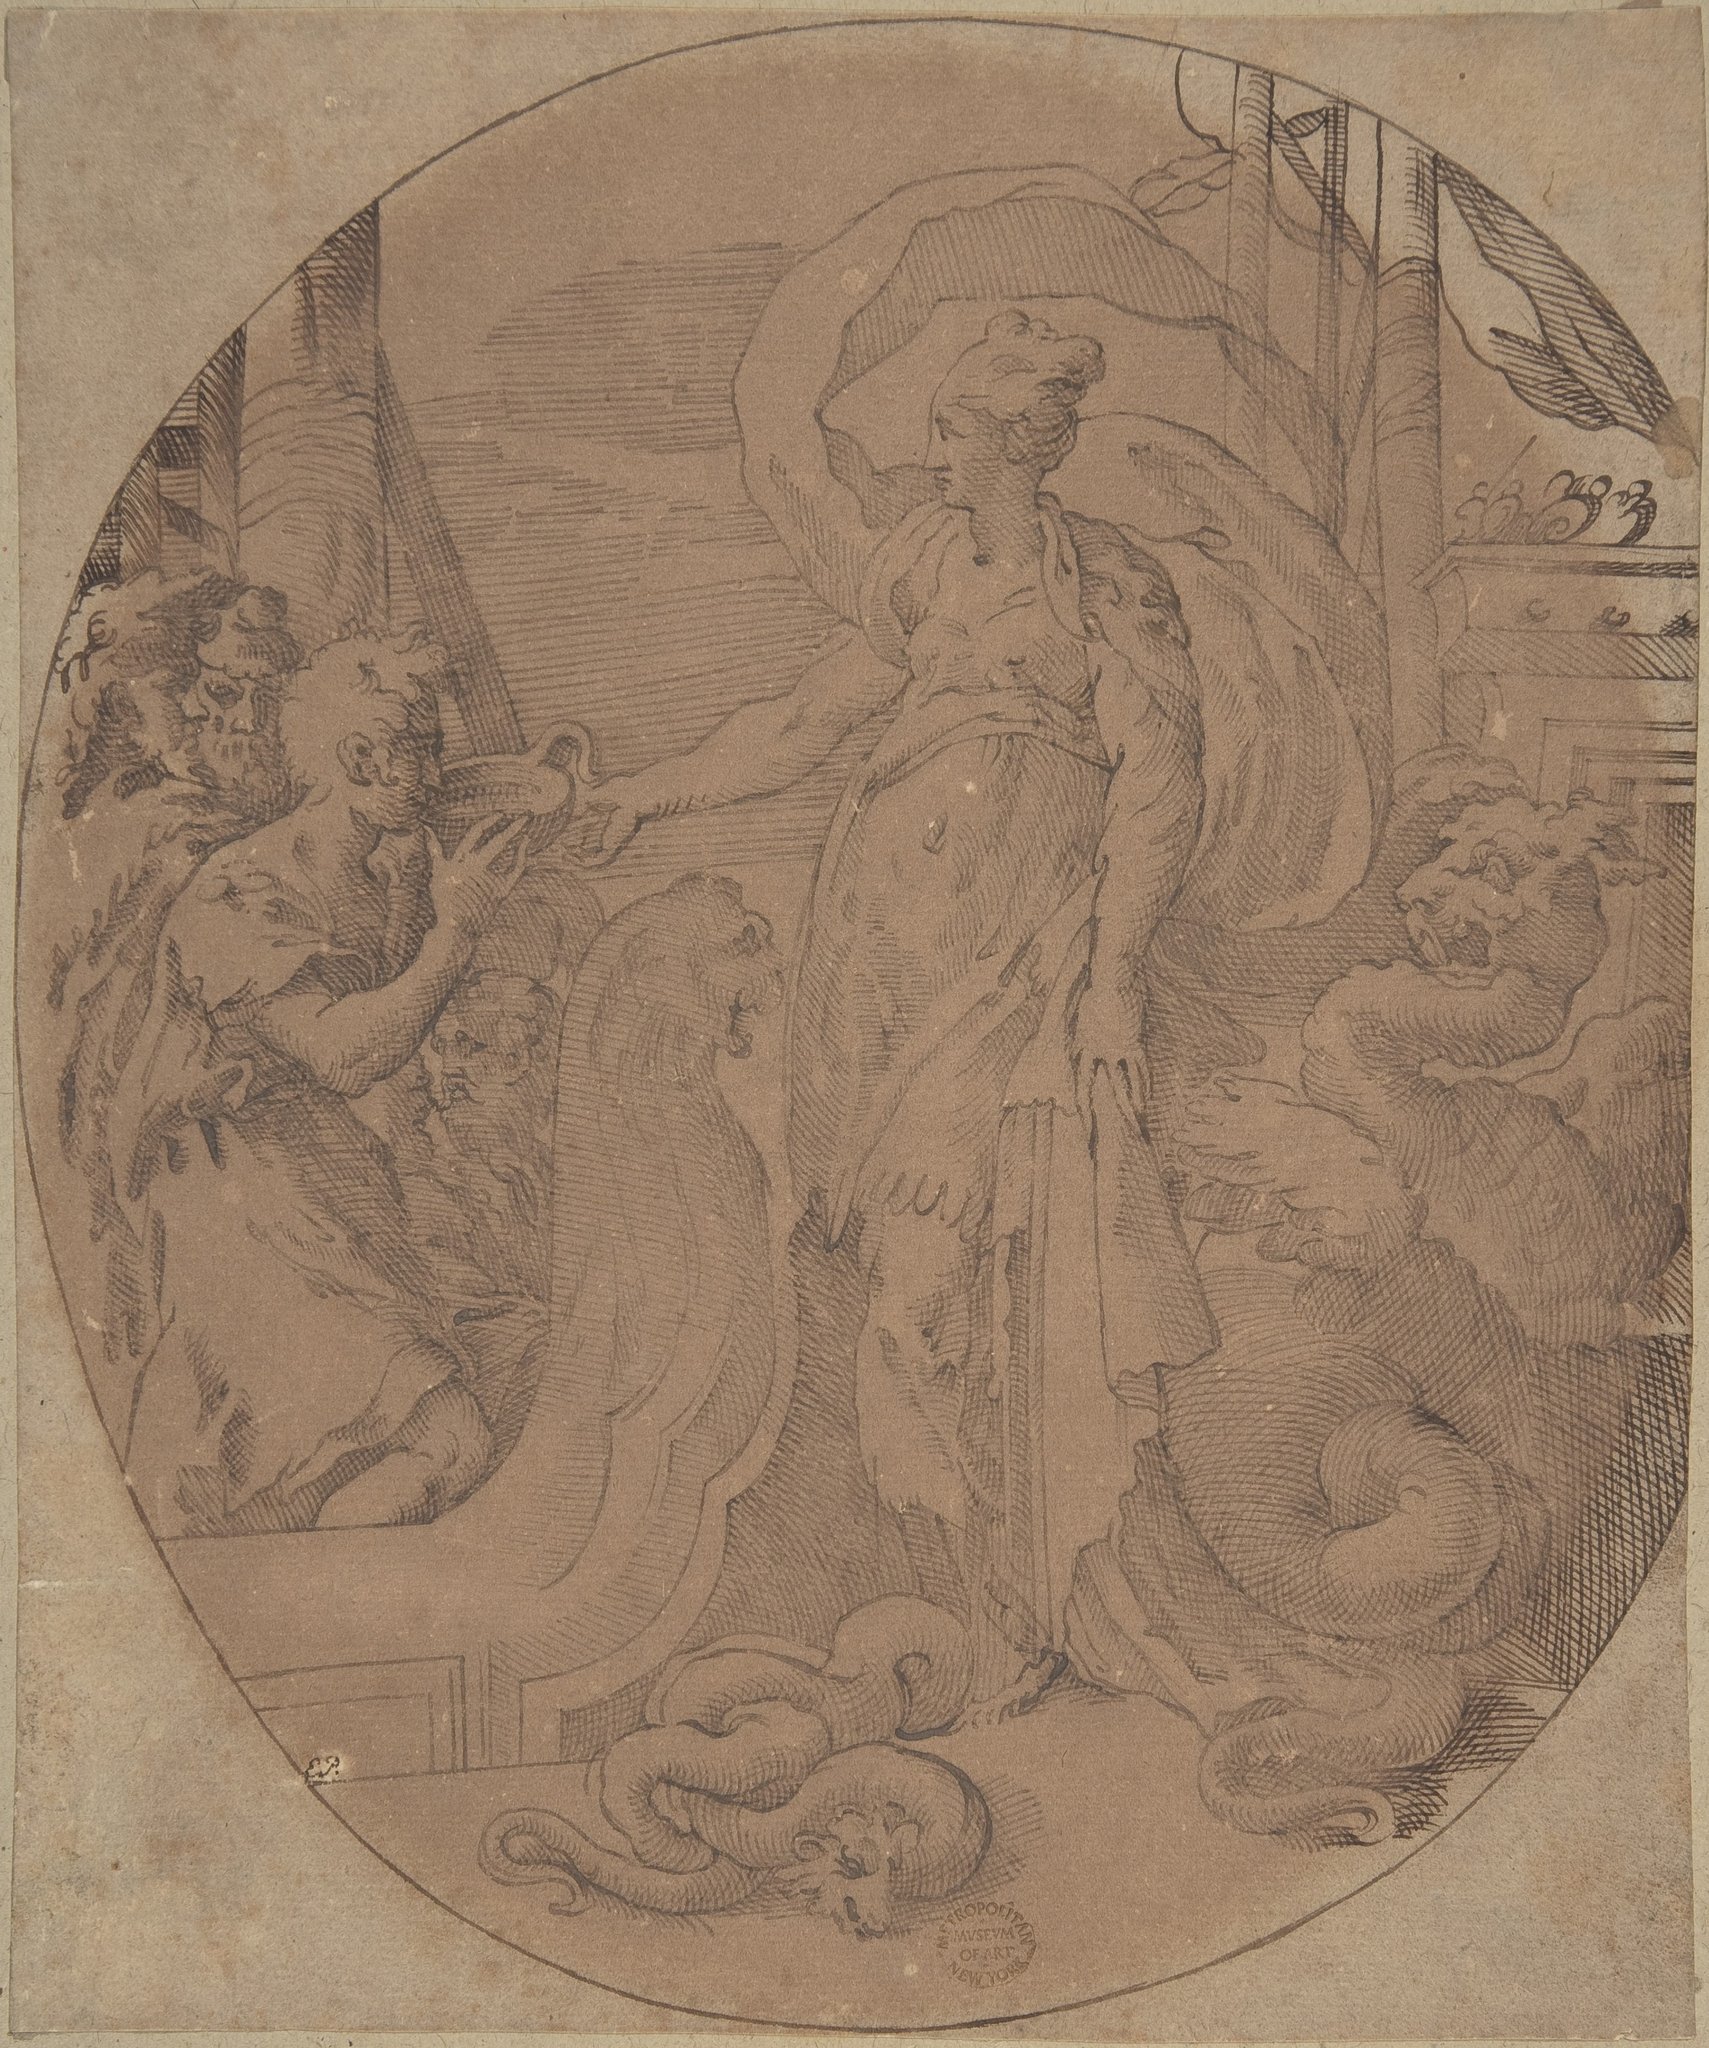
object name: drawing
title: Circe and the Companions of Ulysses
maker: anonymous, italian, 16th century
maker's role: artist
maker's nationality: italian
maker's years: 1550-1600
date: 1501-1600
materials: ink, paper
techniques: pen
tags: men,women,mythical creatures,drinking